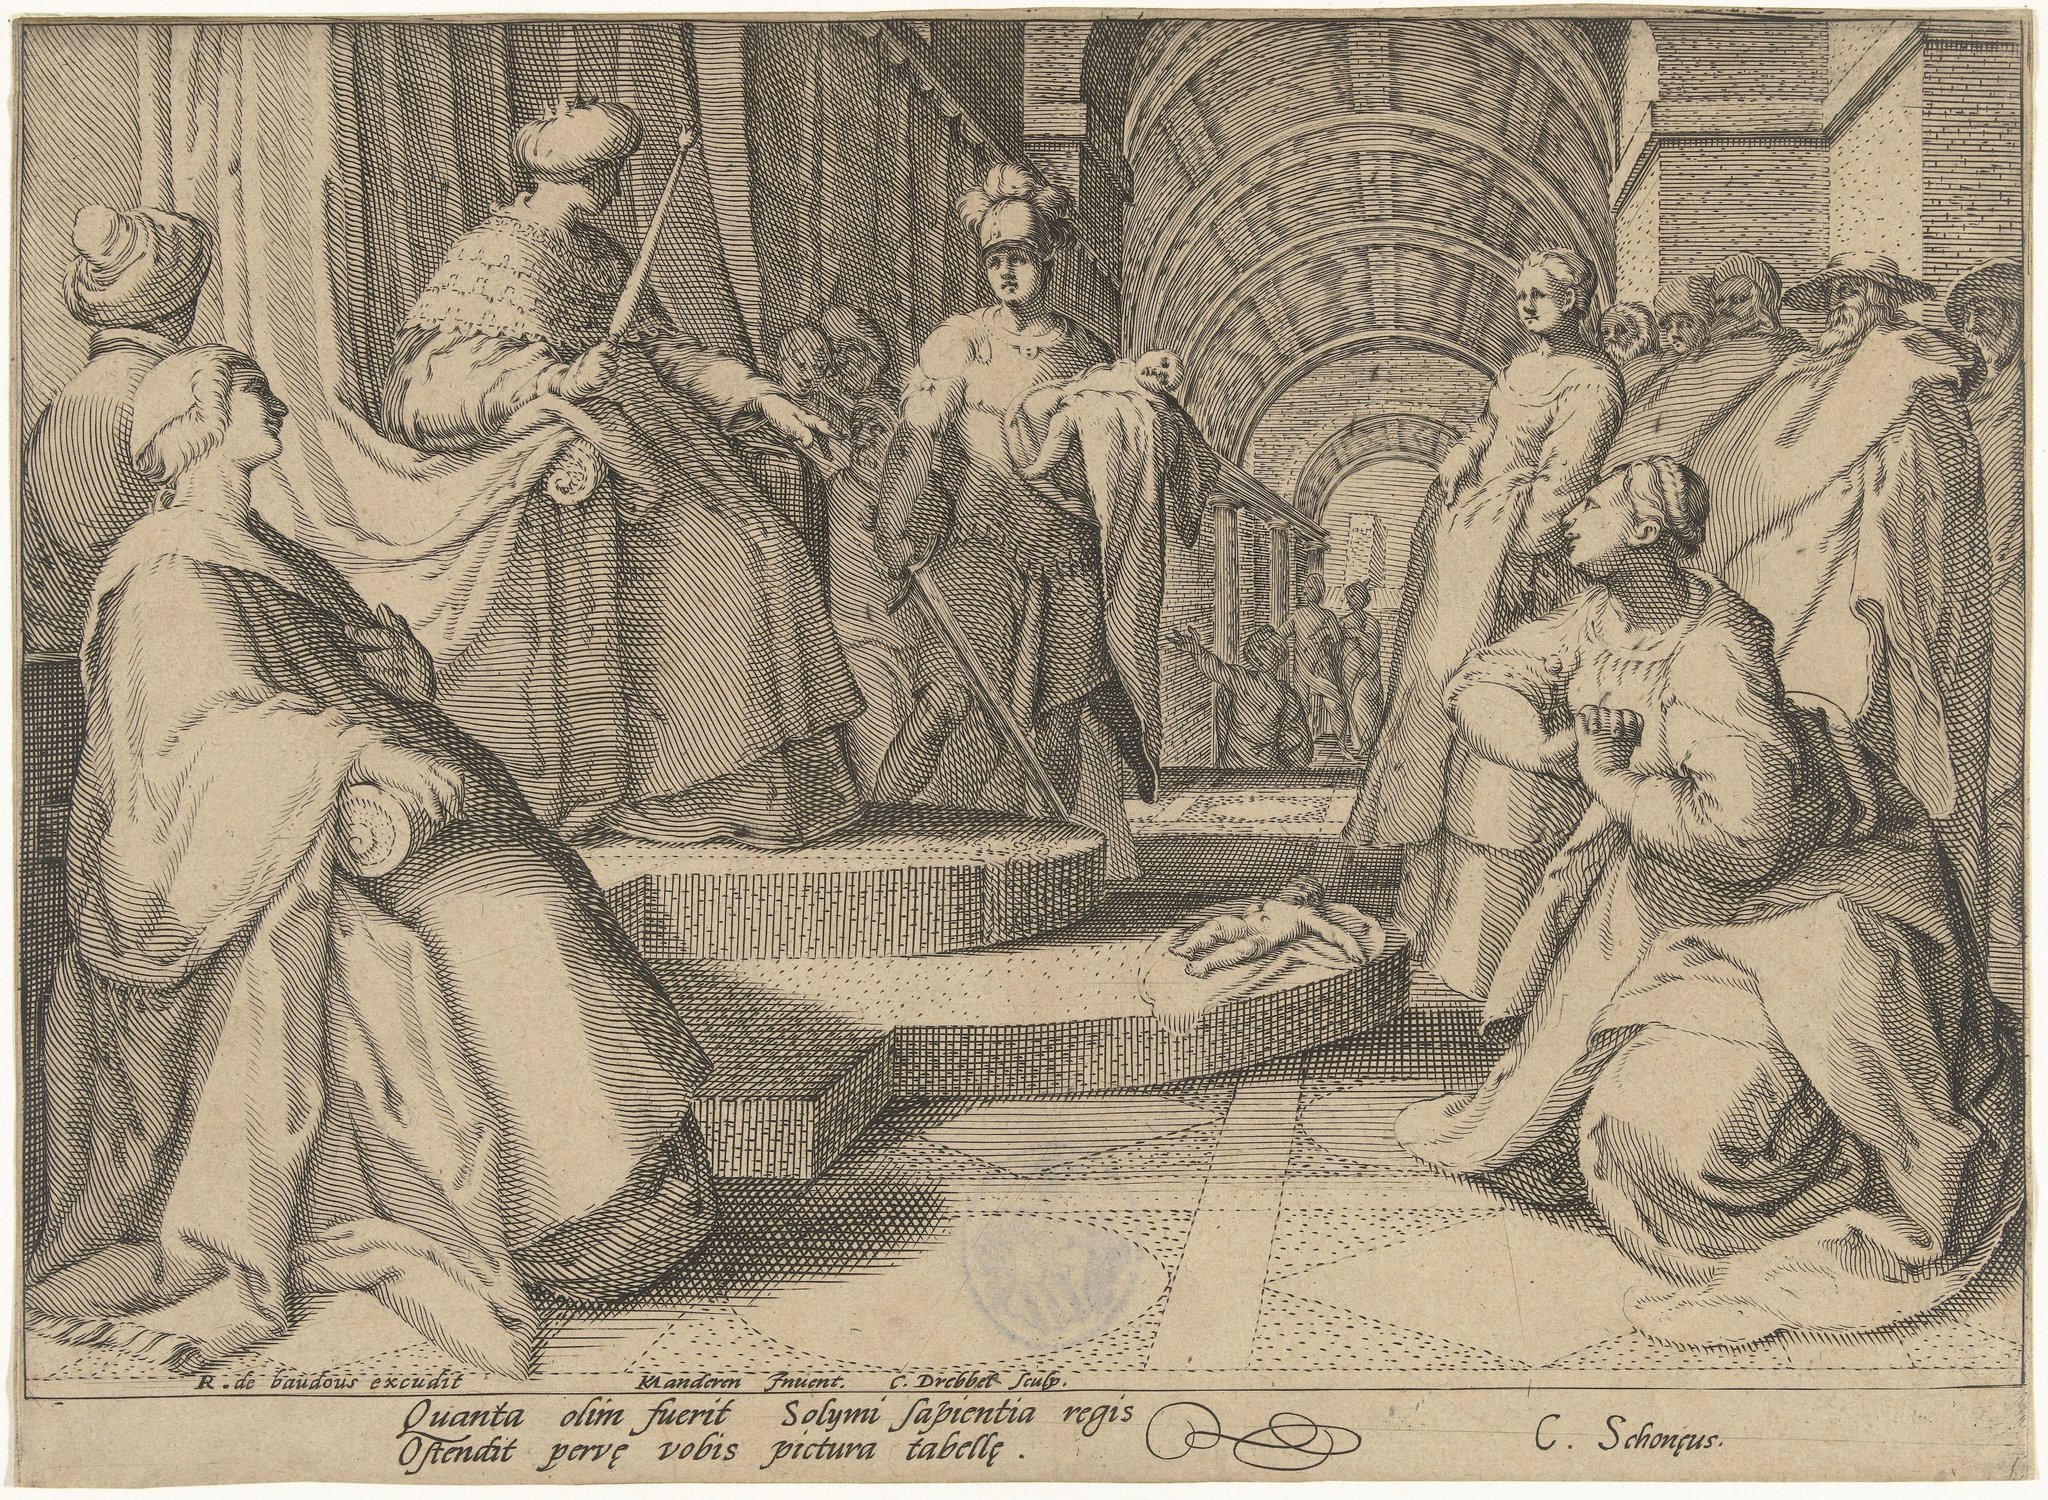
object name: print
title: Oordeel van Salomon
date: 1597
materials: paper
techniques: engraving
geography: netherlands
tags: the judgement of solomon (1 kings 3:16-28)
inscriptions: collector's mark: Lugt 2698, collector's mark: Lugt 2228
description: Salomon zit op zijn troon met de scepter in zijn hand. Voor hem de twee vrouwen die allebei aanspraak maken op hetzelfde kind. De eerste vrouw knielt voor Salomon, de tweede staat en wijst met haar vinger naar het kind. Op de grond voor de troon ligt het dode kind. Een soldaat met een zwaard houdt het levende kind in zijn arm. Pendant van een prent met Ester voor koning Ahasveros.